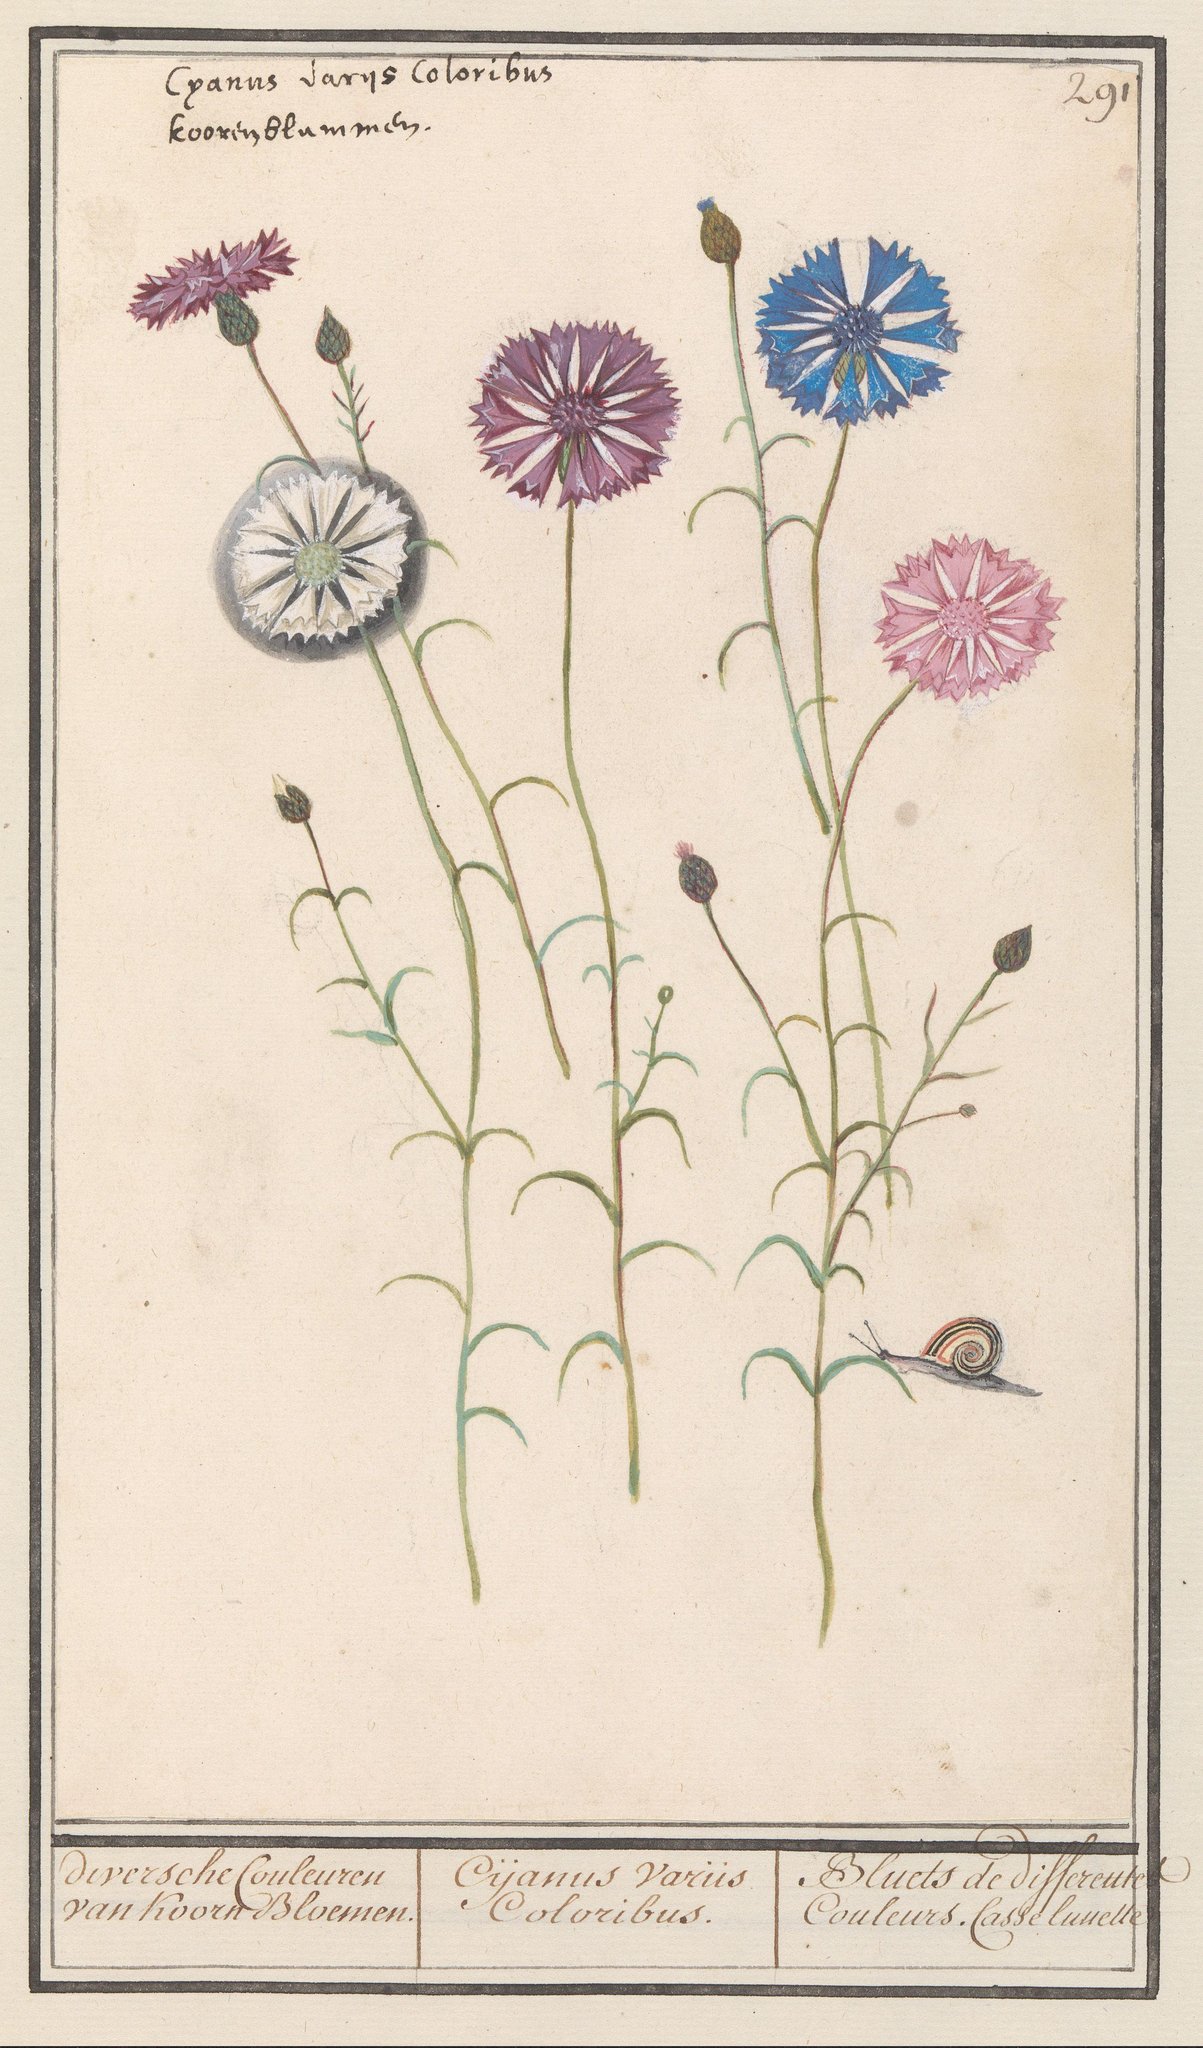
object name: drawing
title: Korenbloem (Centaurea cyanus)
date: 1596-1610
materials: chalk, paint, ink, paper, watercolor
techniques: brush, pen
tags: flowers: cornflower, molluscs: snail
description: Korenbloemen in wit, paars en blauw. Met een slak. Genummerd rechtsboven: 291. Linksboven de naam in Latijn en Nederlands. Onderdeel van het derde album met tekeningen van bloemen en planten. Tiende van twaalf albums met tekeningen van dieren, vogels en planten bekend rond 1600, gemaakt in opdracht van keizer Rudolf II. Met toelichting in Nederlands, Latijn en Frans.